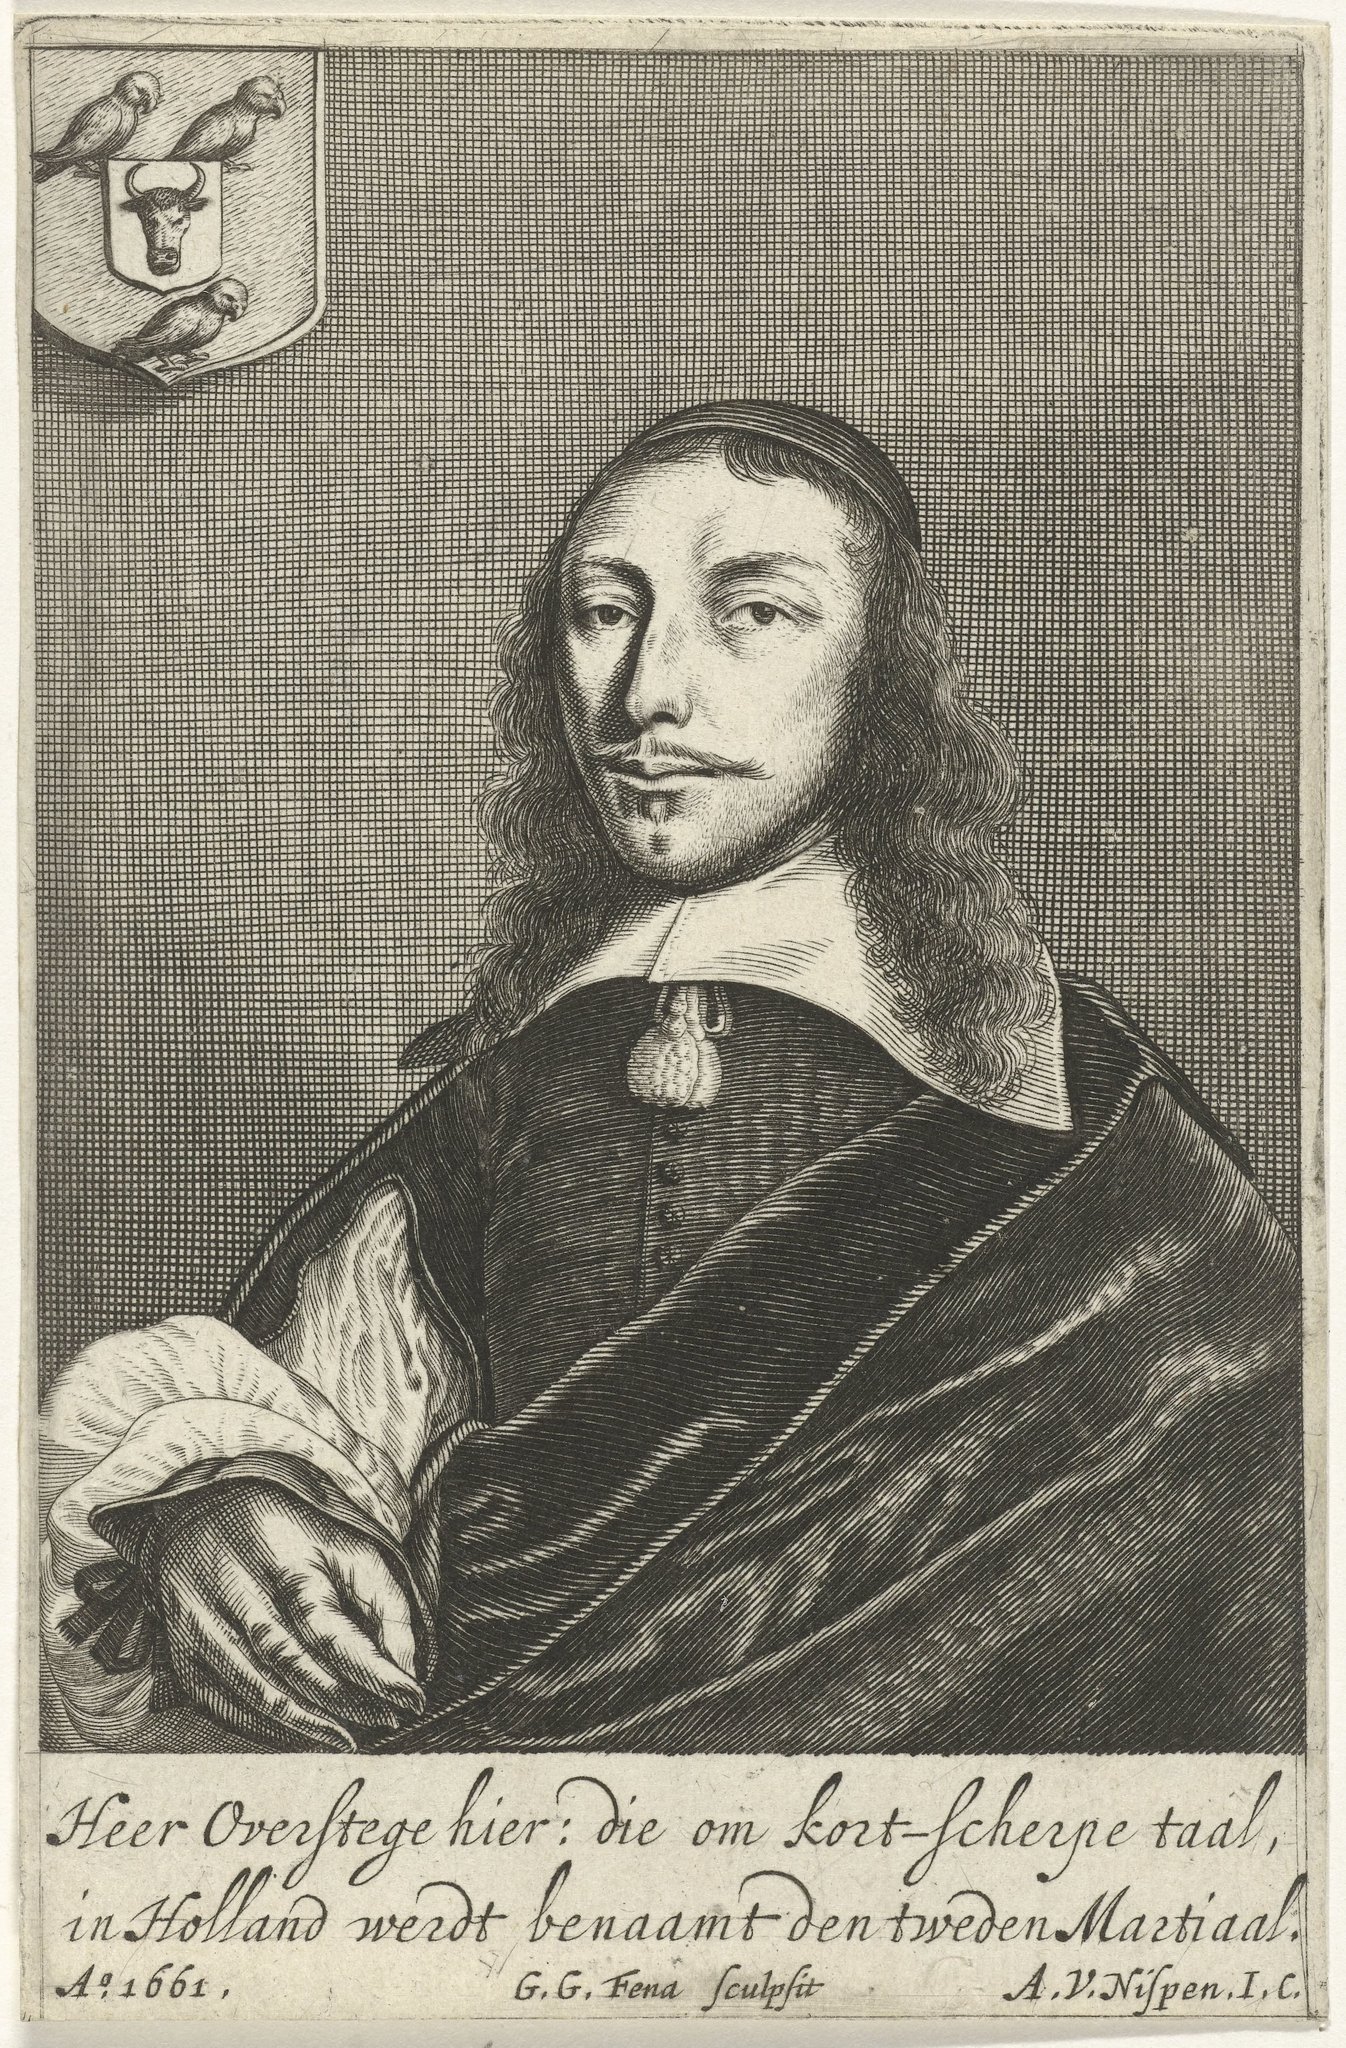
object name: print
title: Portret van Cornelis van Overstege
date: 1661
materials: paper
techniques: engraving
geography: netherlands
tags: netherlands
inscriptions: collector's mark: Lugt 2228, collector's mark: Lugt 1120 / 1121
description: Portret van de Dortse dichter Cornelis van Overstege. Hij is ten halven lijve afgebeeld met hoofddeksel, platte witte kraag en een mantel. Linksboven zijn wapen. Onder het portret een Nederlands vers van twee regels.